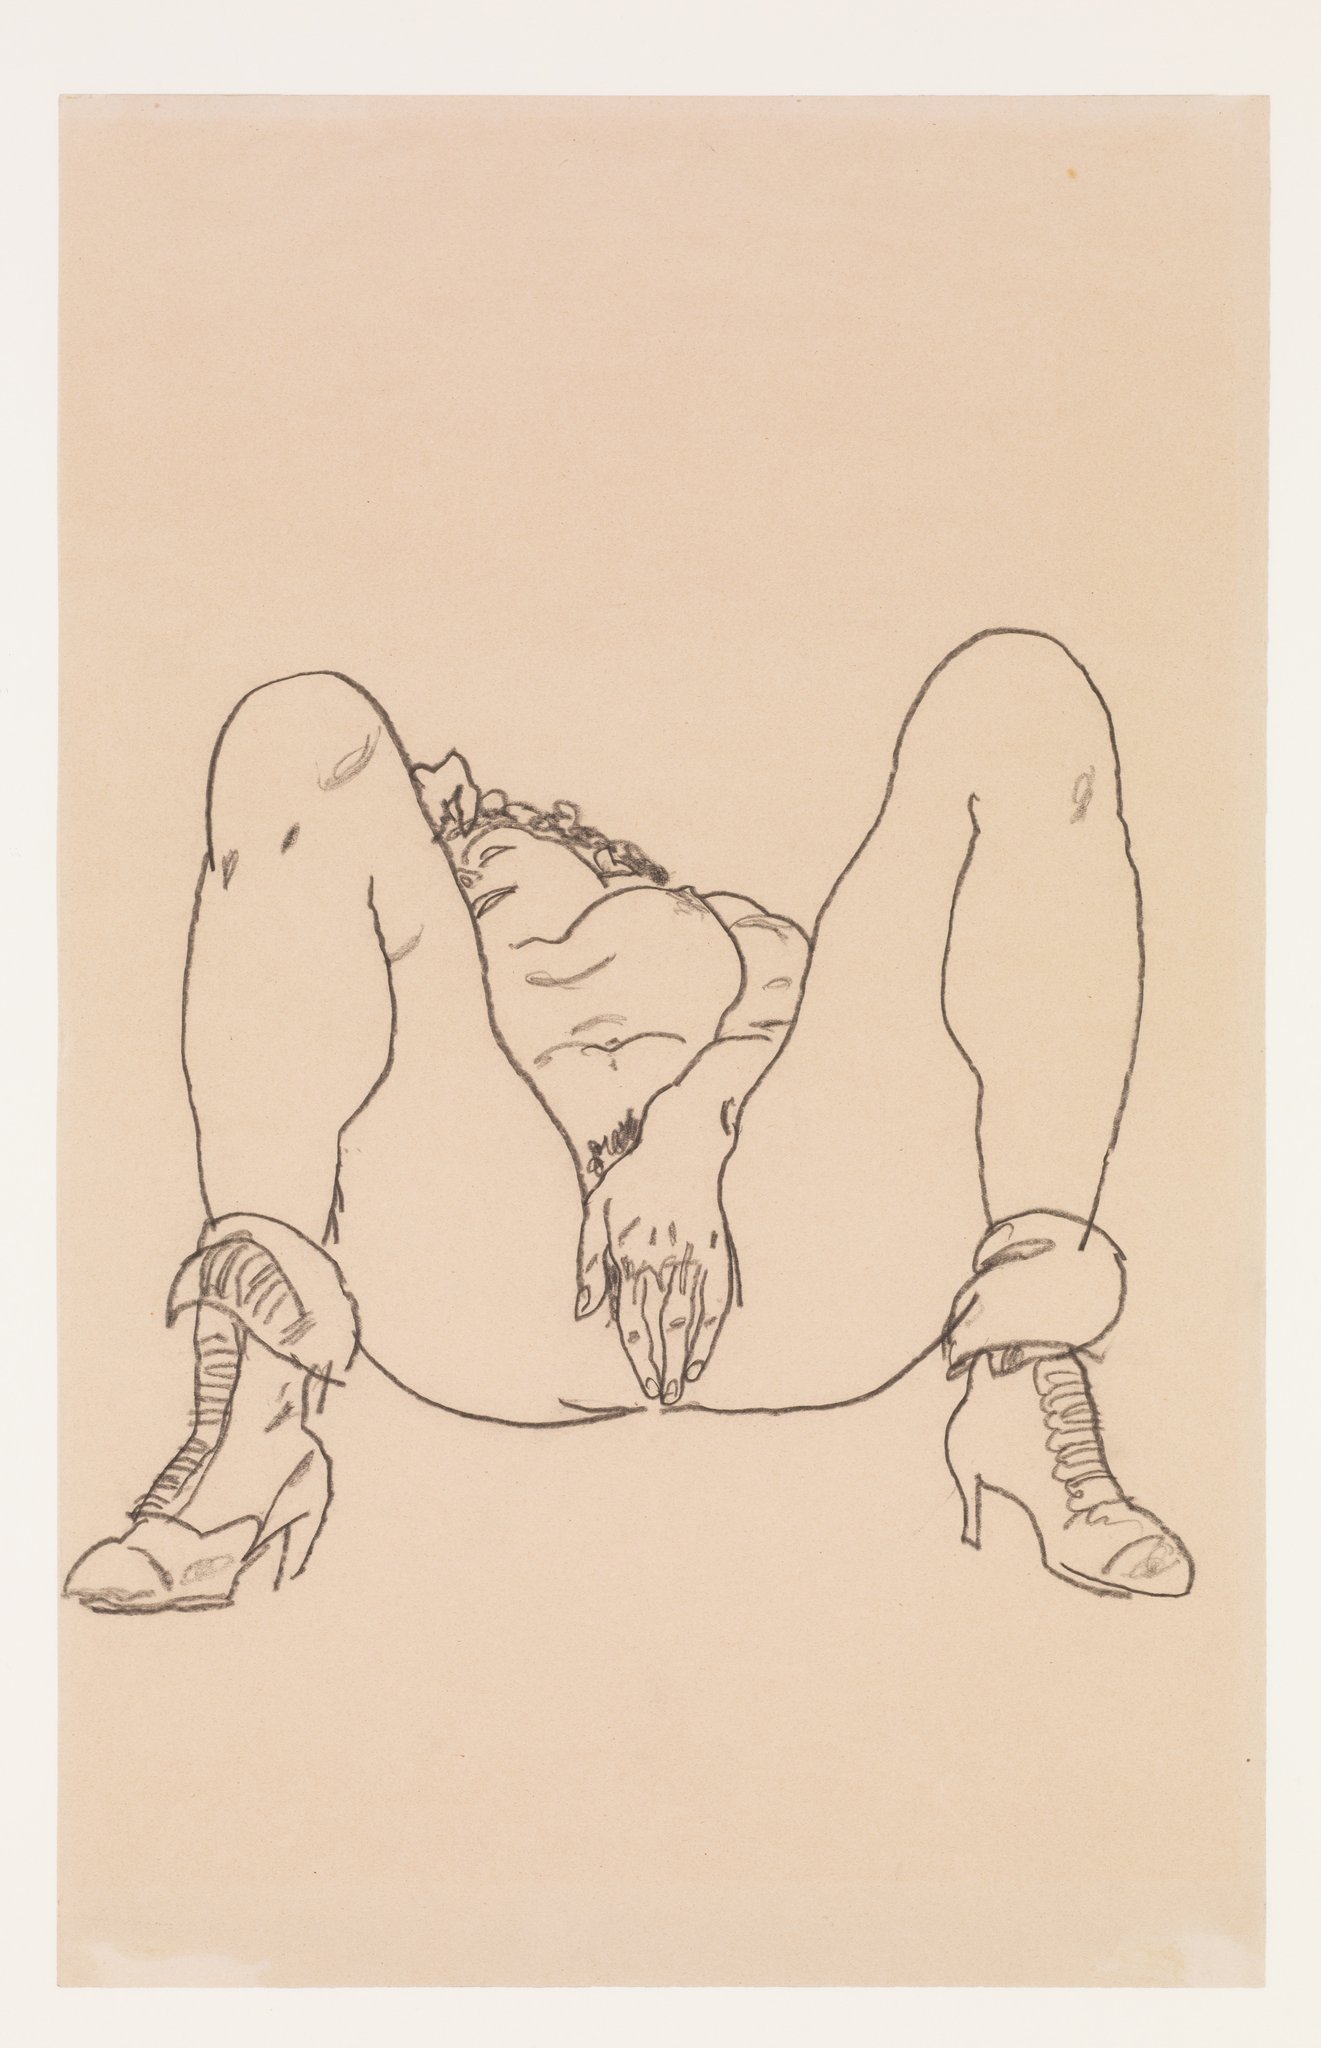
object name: drawing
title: Reclining Nude with Boots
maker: egon schiele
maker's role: artist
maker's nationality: austrian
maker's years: 1890-1918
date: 1918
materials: charcoal, paper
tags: female nudes